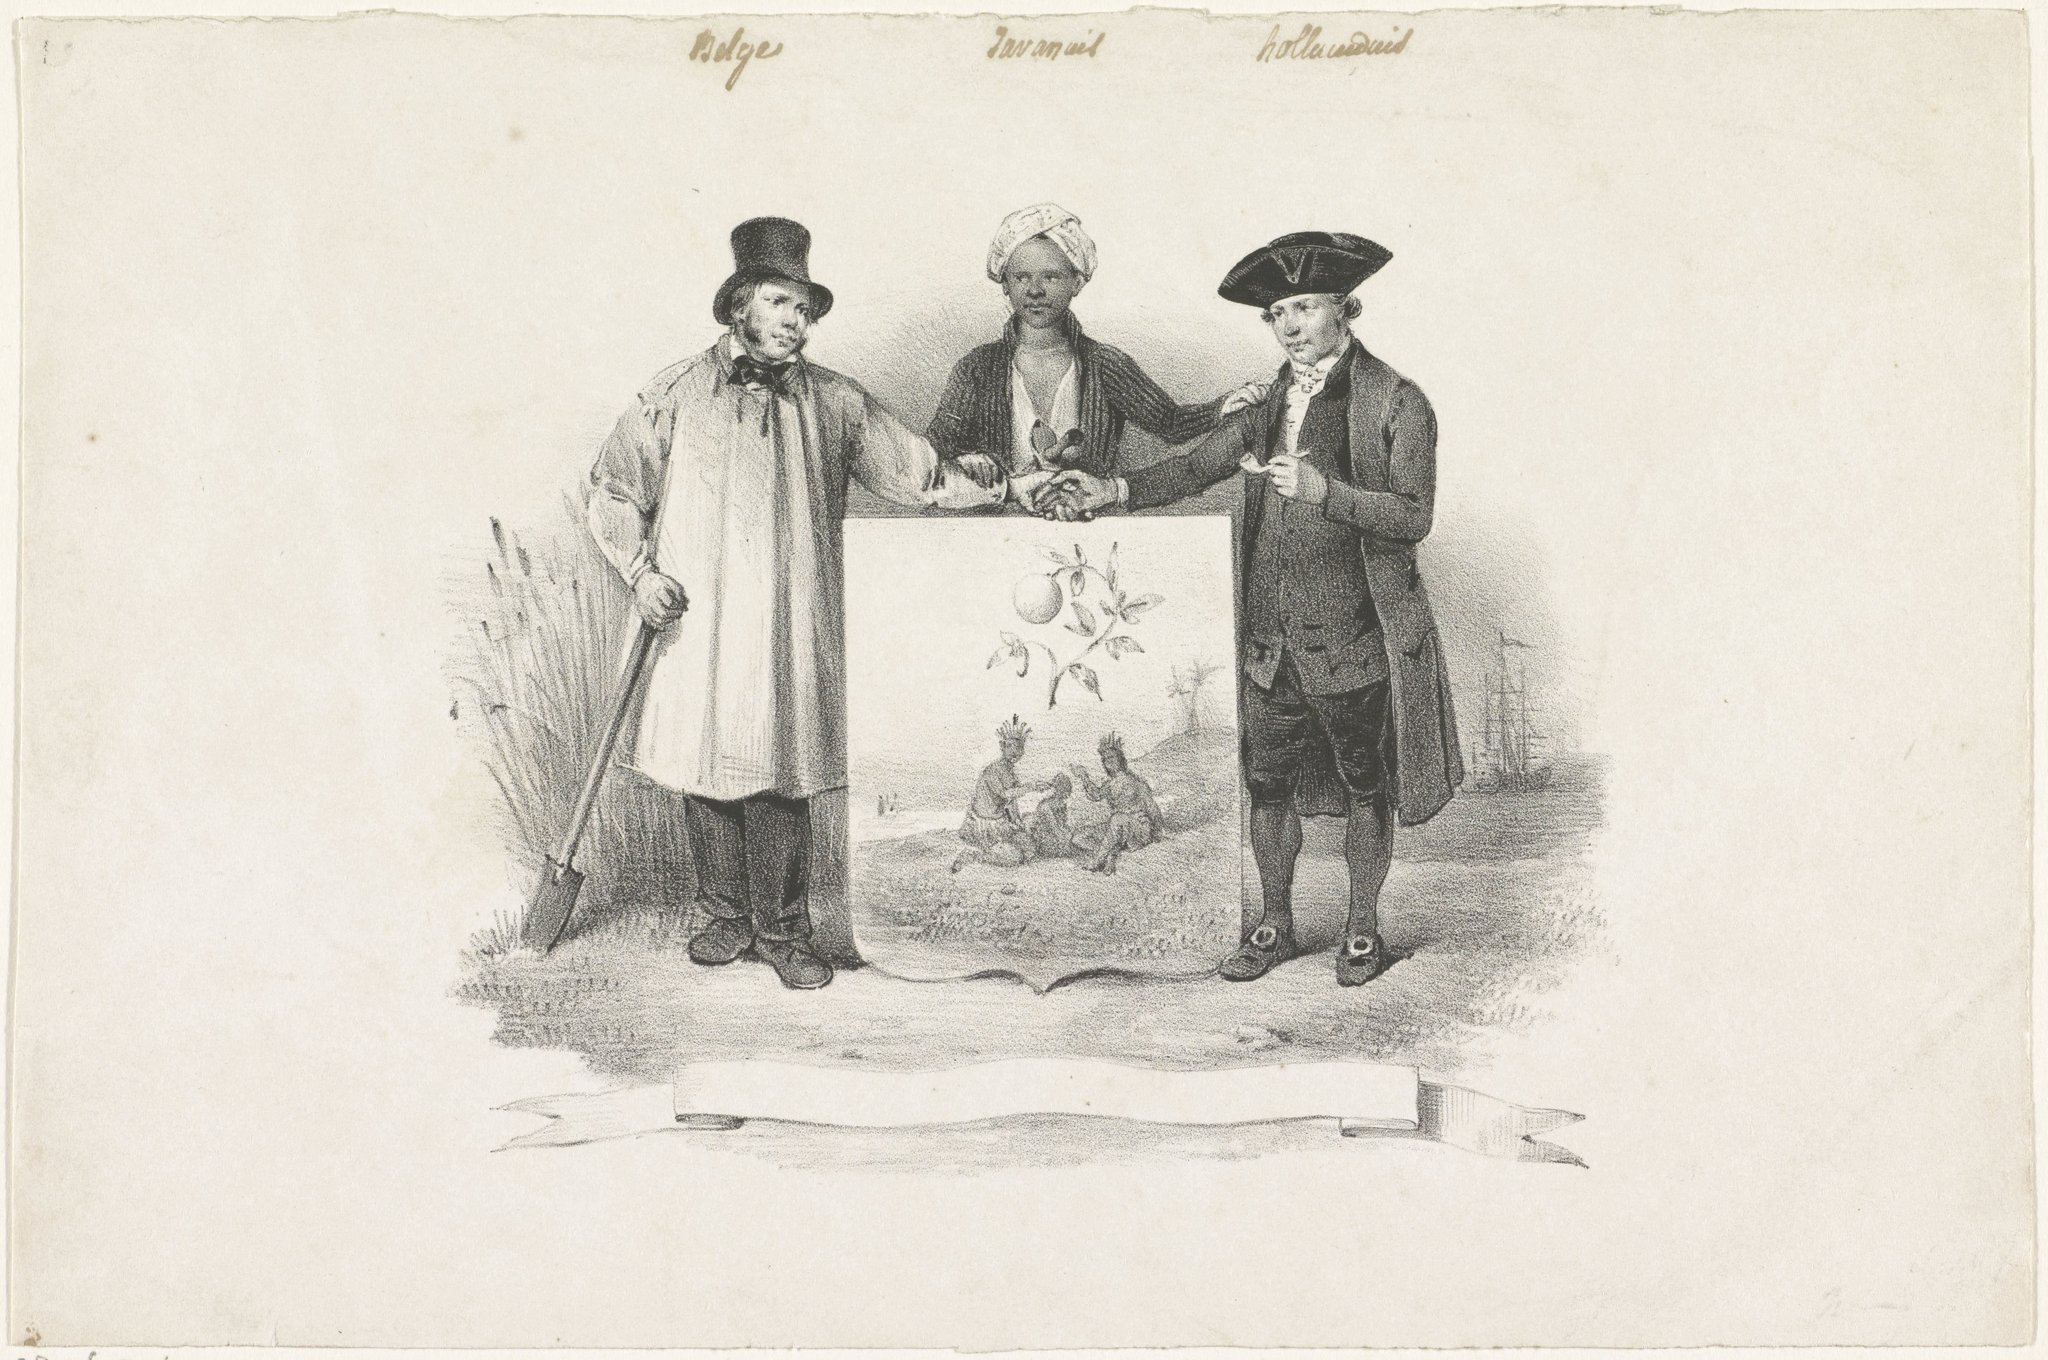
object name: print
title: Wapenschild met Belg, Javaan en Hollander, 1826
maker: Anonymous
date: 1826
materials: paper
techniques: lithograph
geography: netherlands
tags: coat of arms (as symbol of the state, etc.), native peoples of the americas, java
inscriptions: collector's mark: Lugt 2228, inscription: ‘Belge Javanais hollandais’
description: Allegorie met een wapenschild, waarop een oorspronkelijk Amerikaans gezin afgebeeld staat, de man en vrouw gekleed in rok en met verentooi, daarboven een plant met vrucht (sinaasappel?), waarnaast een Belg en een Hollander elkaar de hand geven, terwijl een Javaan achter het schild staat en zijn handen op de armen van beide mannen legt. Onderaan een banderol zonder tekst. Mogelijk een allegorie op de benoeming van Du Bus de Gisignies als Commissaris-Generaal van Oost-Indië, 3 februari 1826.